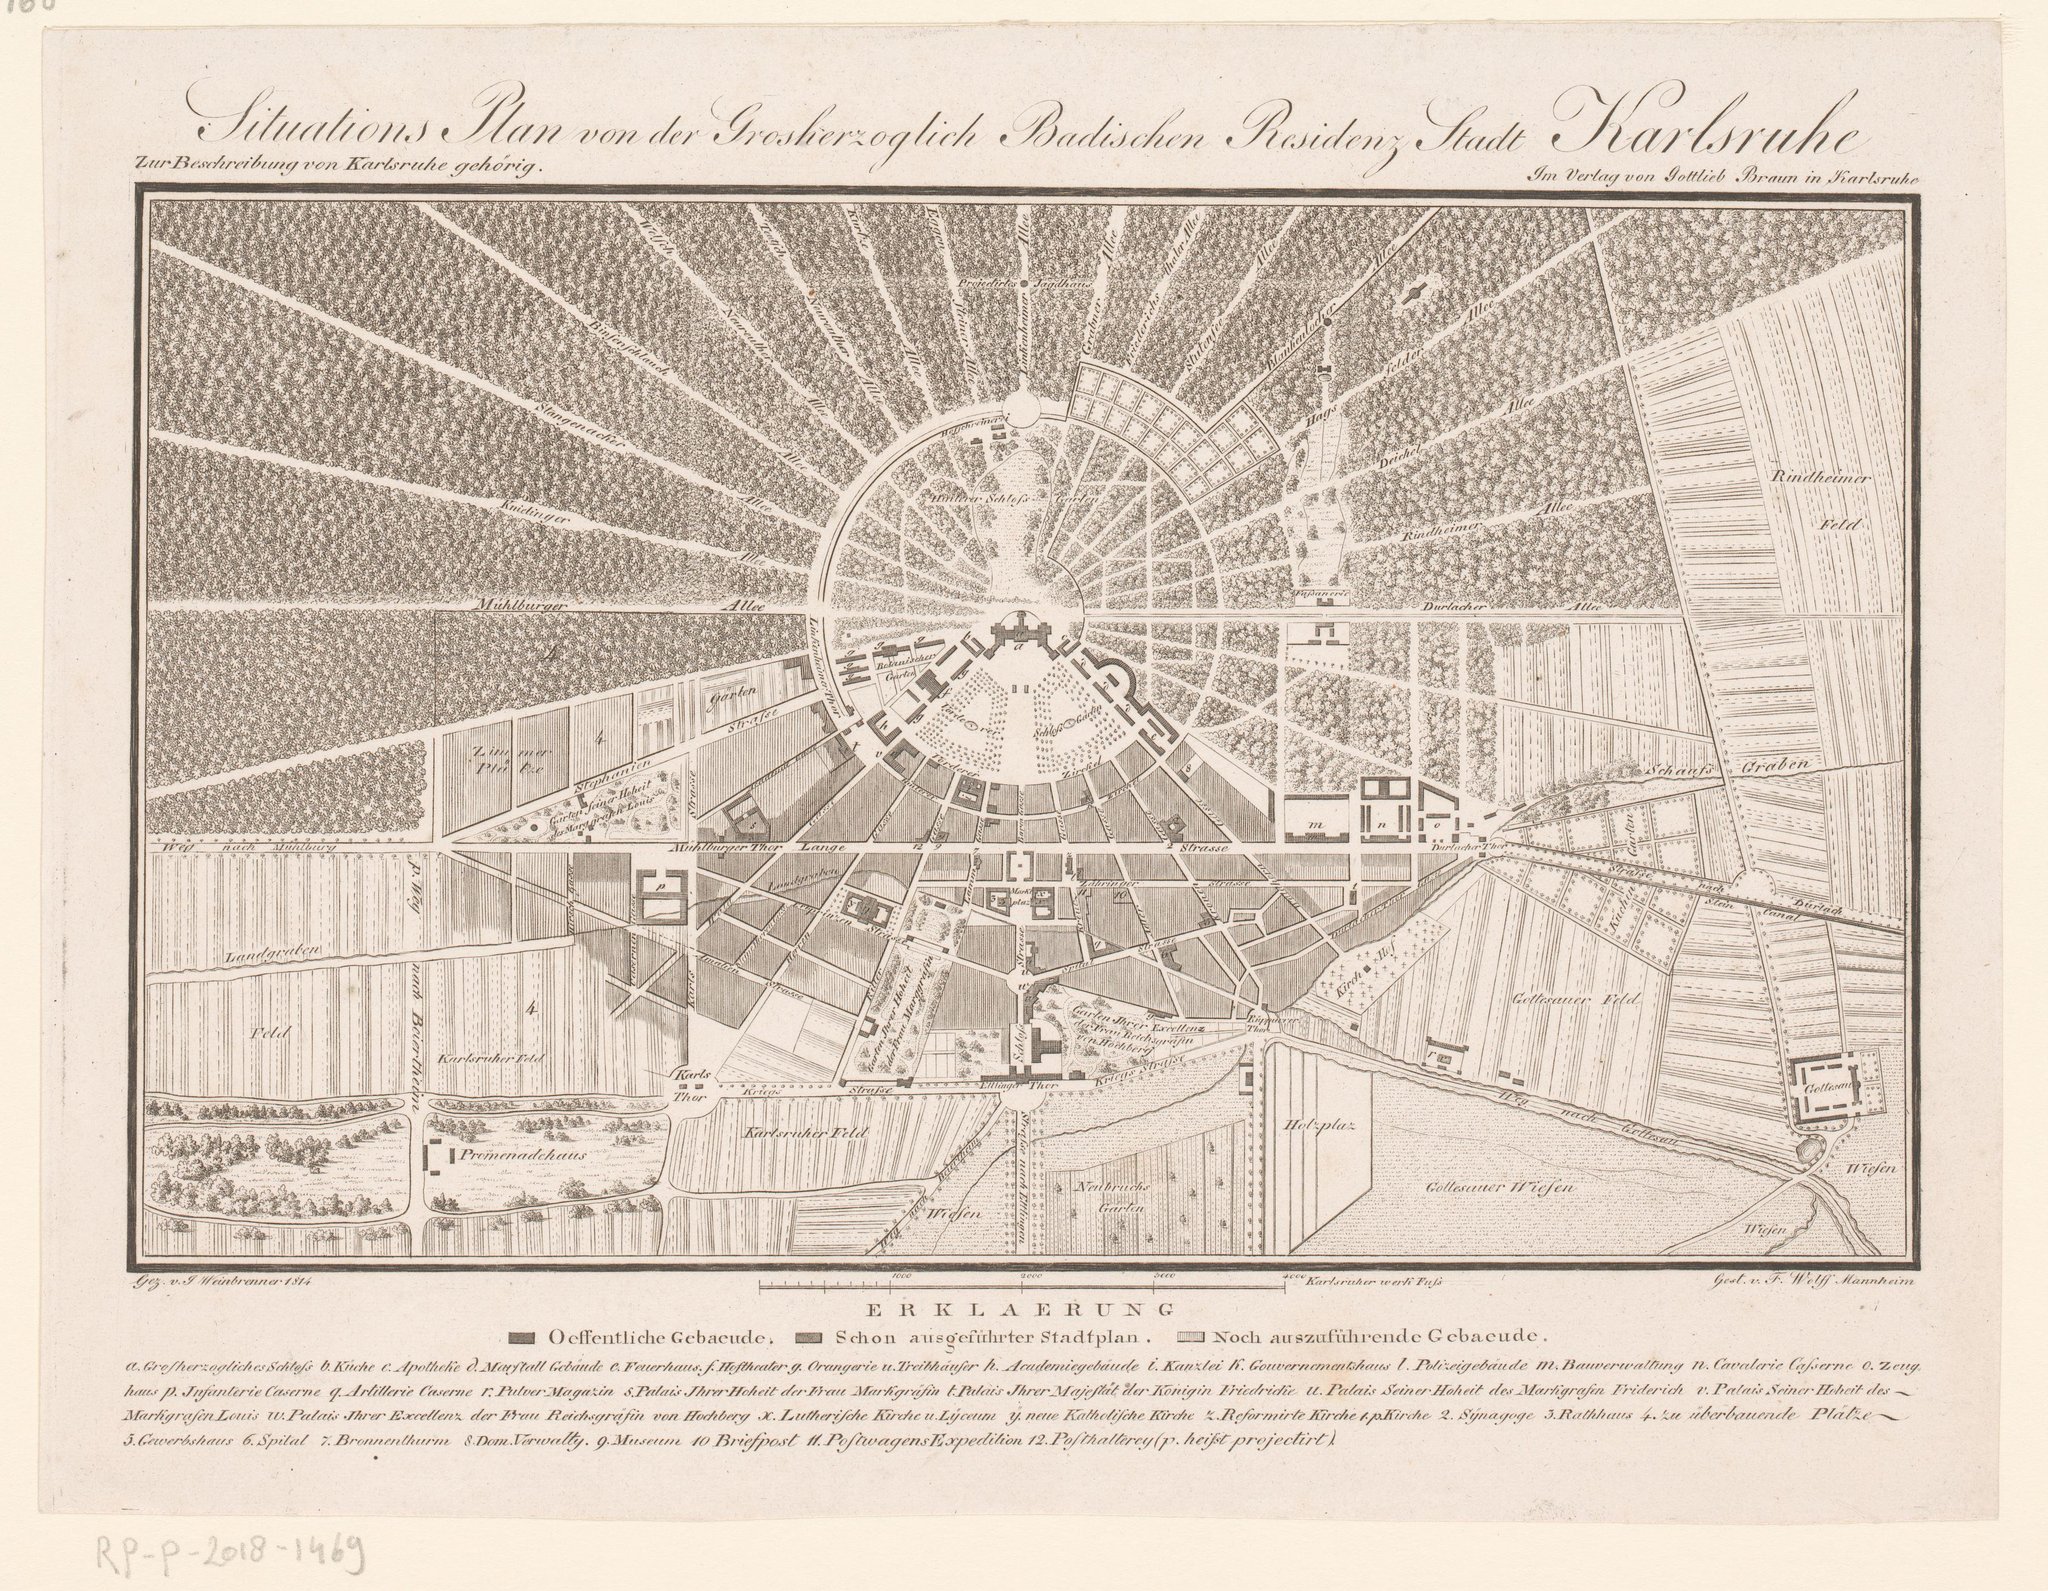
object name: print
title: Plattegrond van Slot Karlsruhe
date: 1814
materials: paper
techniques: engraving, etching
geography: mannheim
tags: plan, map of garden, palace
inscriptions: collector's mark: Lugt 2228